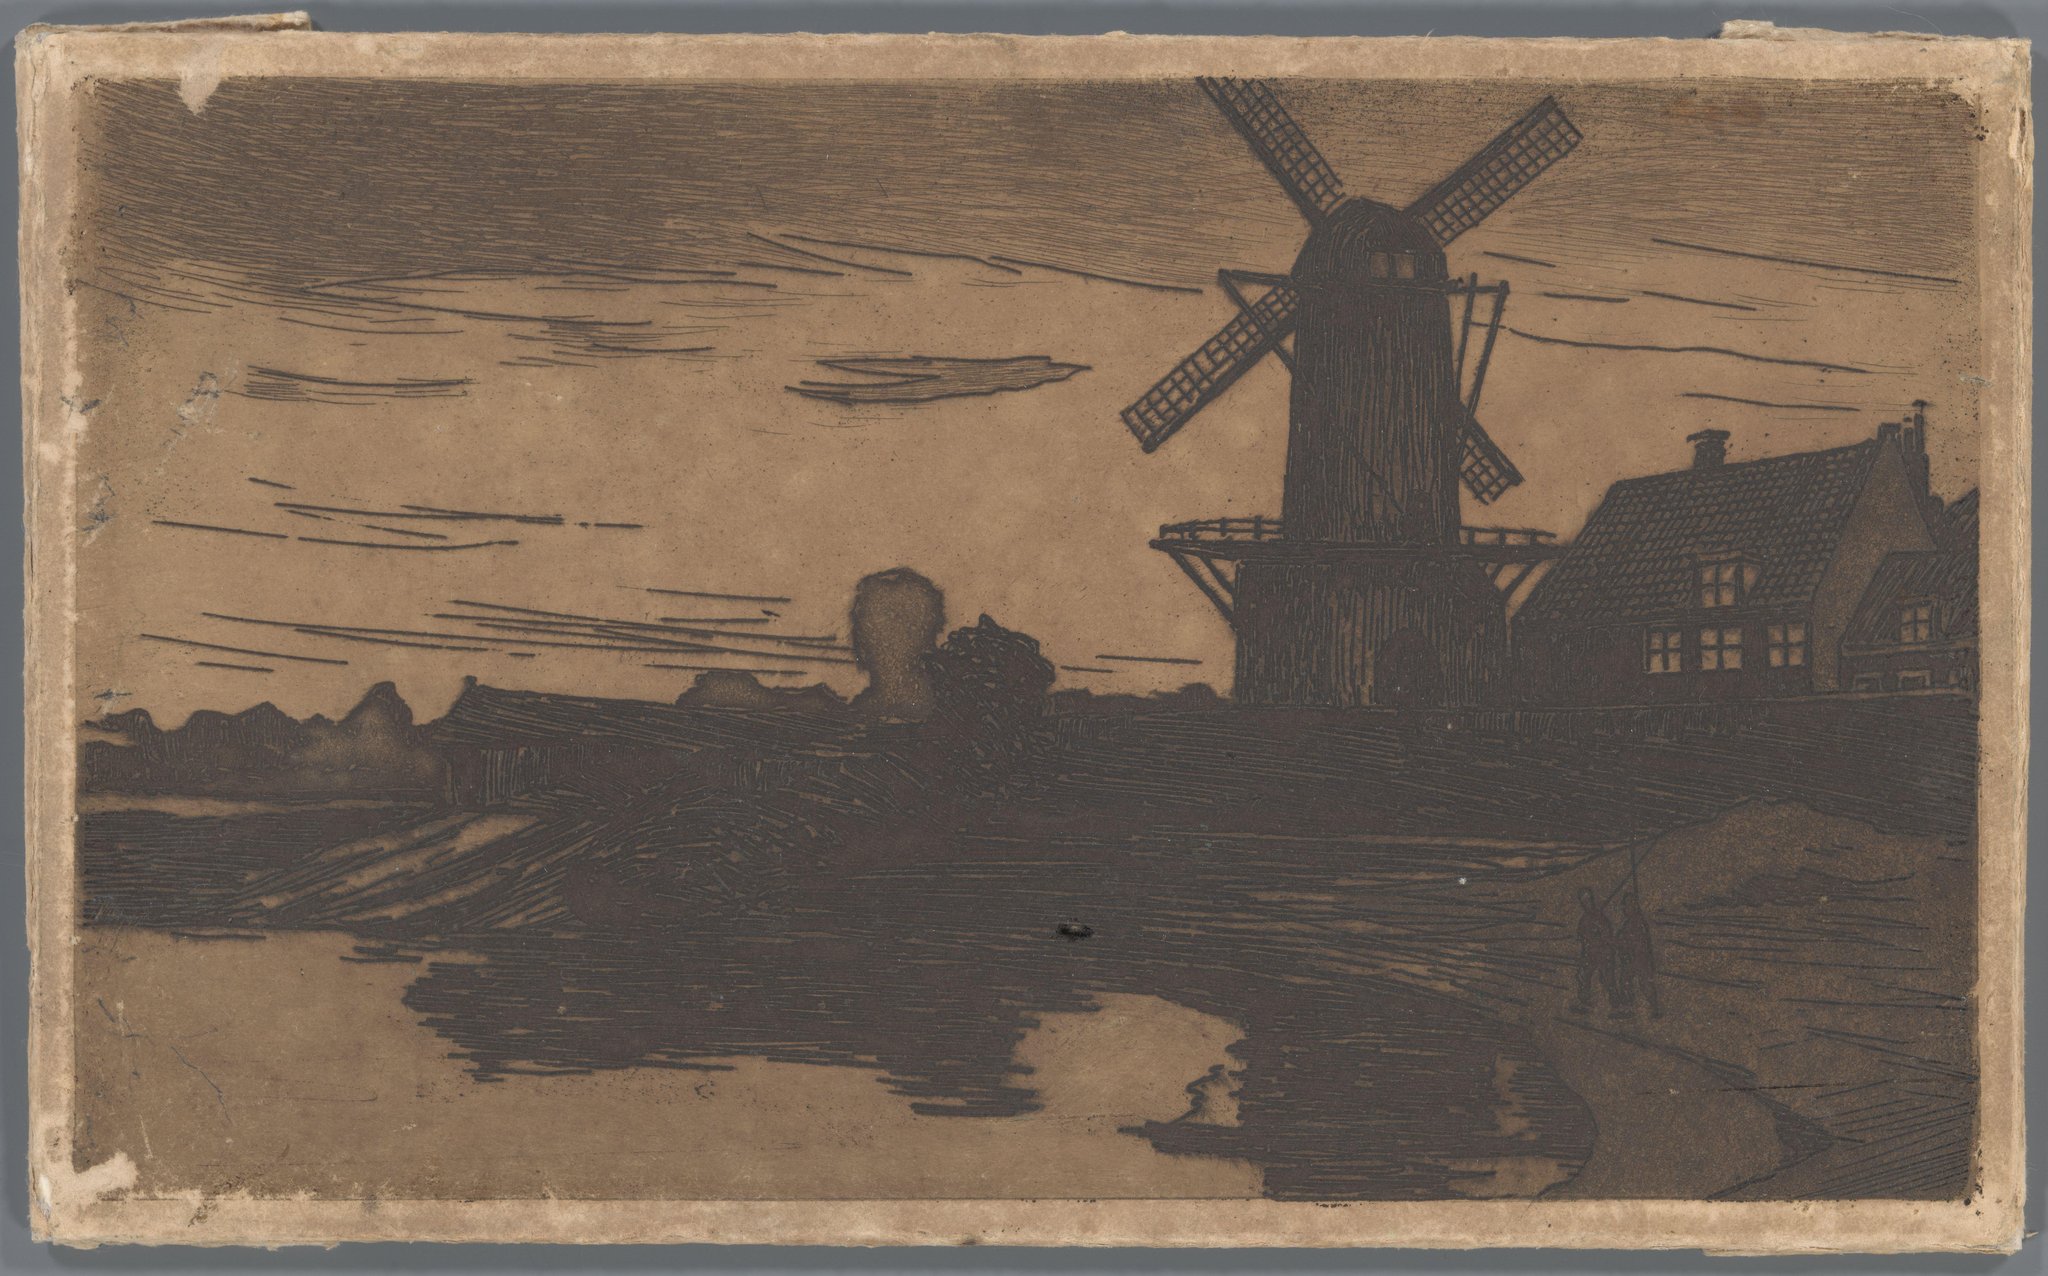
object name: print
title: Molen aan water, Wijk bij Duurstede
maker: willem witsen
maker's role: draughtsman, painter, print maker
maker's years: 1860-1923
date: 1906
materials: paper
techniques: aquatint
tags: windmill in landscape, wijk bij duurstede